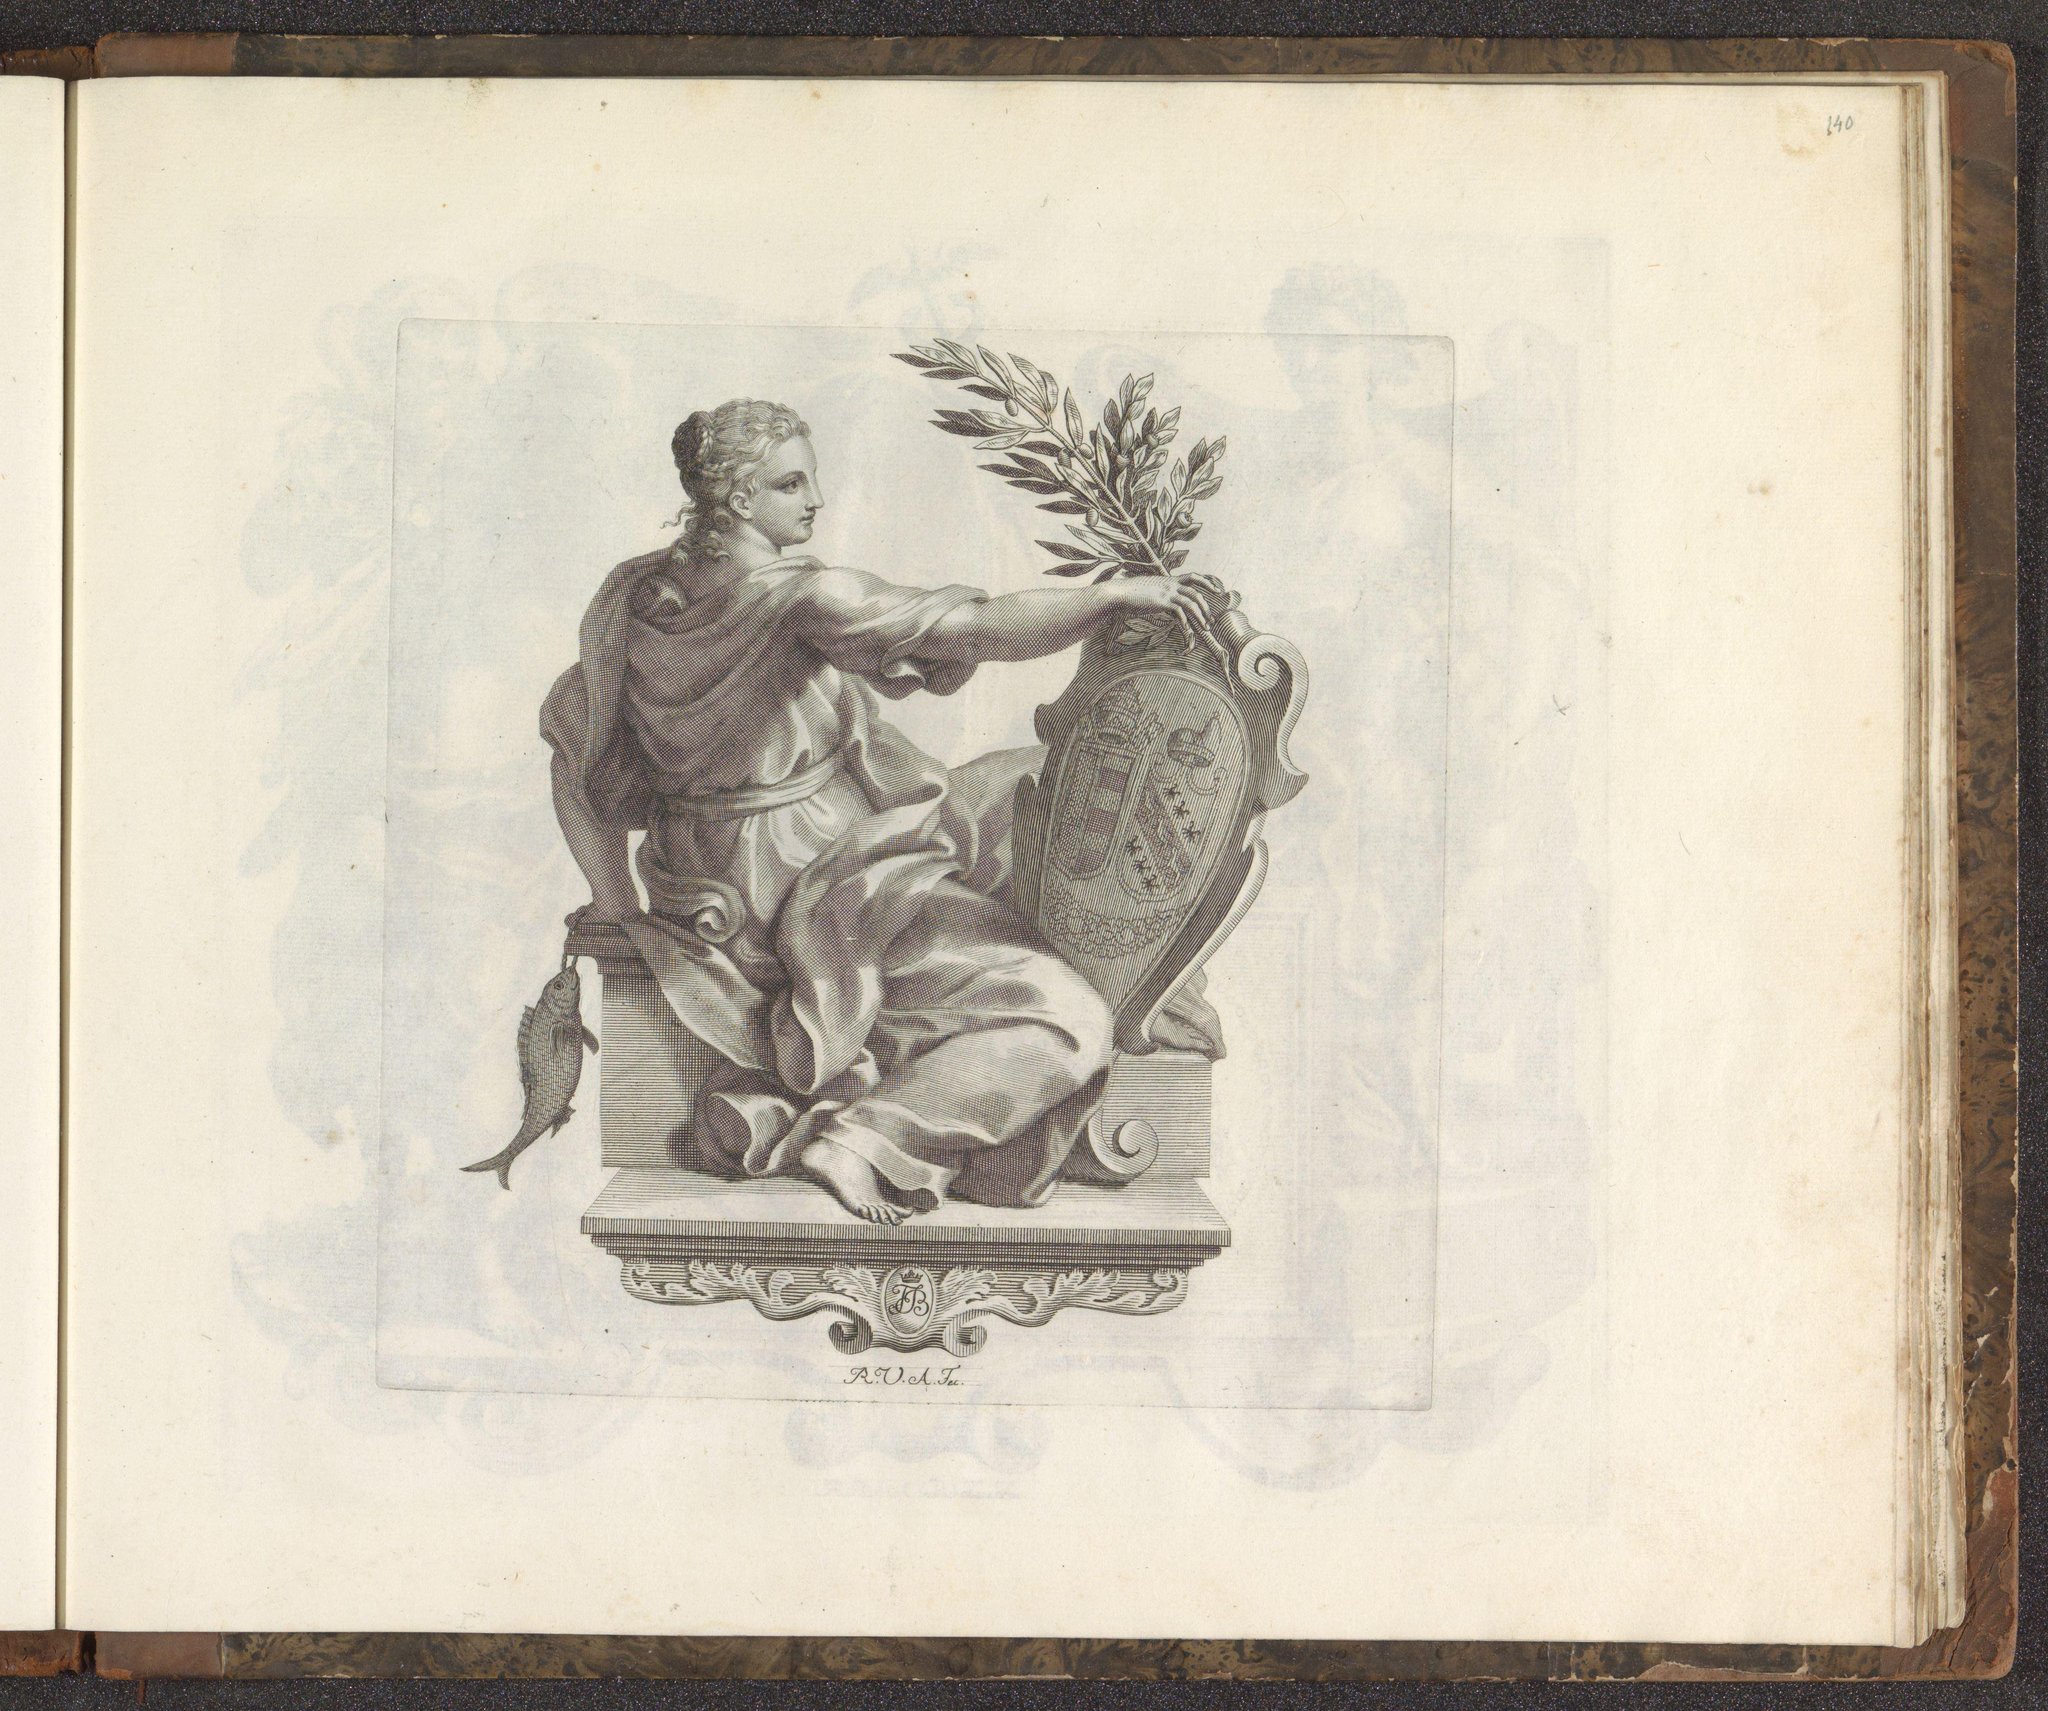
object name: print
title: Numismata virorum illustrium ex Barbadica gente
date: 1673-1743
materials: paper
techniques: engraving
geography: rome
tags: coat of arms (as symbol of the state, etc.), agreement, unity; 'concordia', 'concordia insuperabile', 'concordia militare', 'concordia di pace', 'unione civile' (ripa), fishes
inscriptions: collector's mark: Lugt 2228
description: Een console met de personificatie van Burgerlijke Eendracht, weergegeven als een vrouw met in haar rechterhand een olijftak omkrultd met een mirtekrans. In haar andere hand heeft ze een vis. Daarbij een bord met twee wapenschilden. Rechts het wapen van de familie Barbarigo met daarboven een dogehoed. Links het pauselijk wapen van Alexander VI. De prent maakt deel uit van een album.